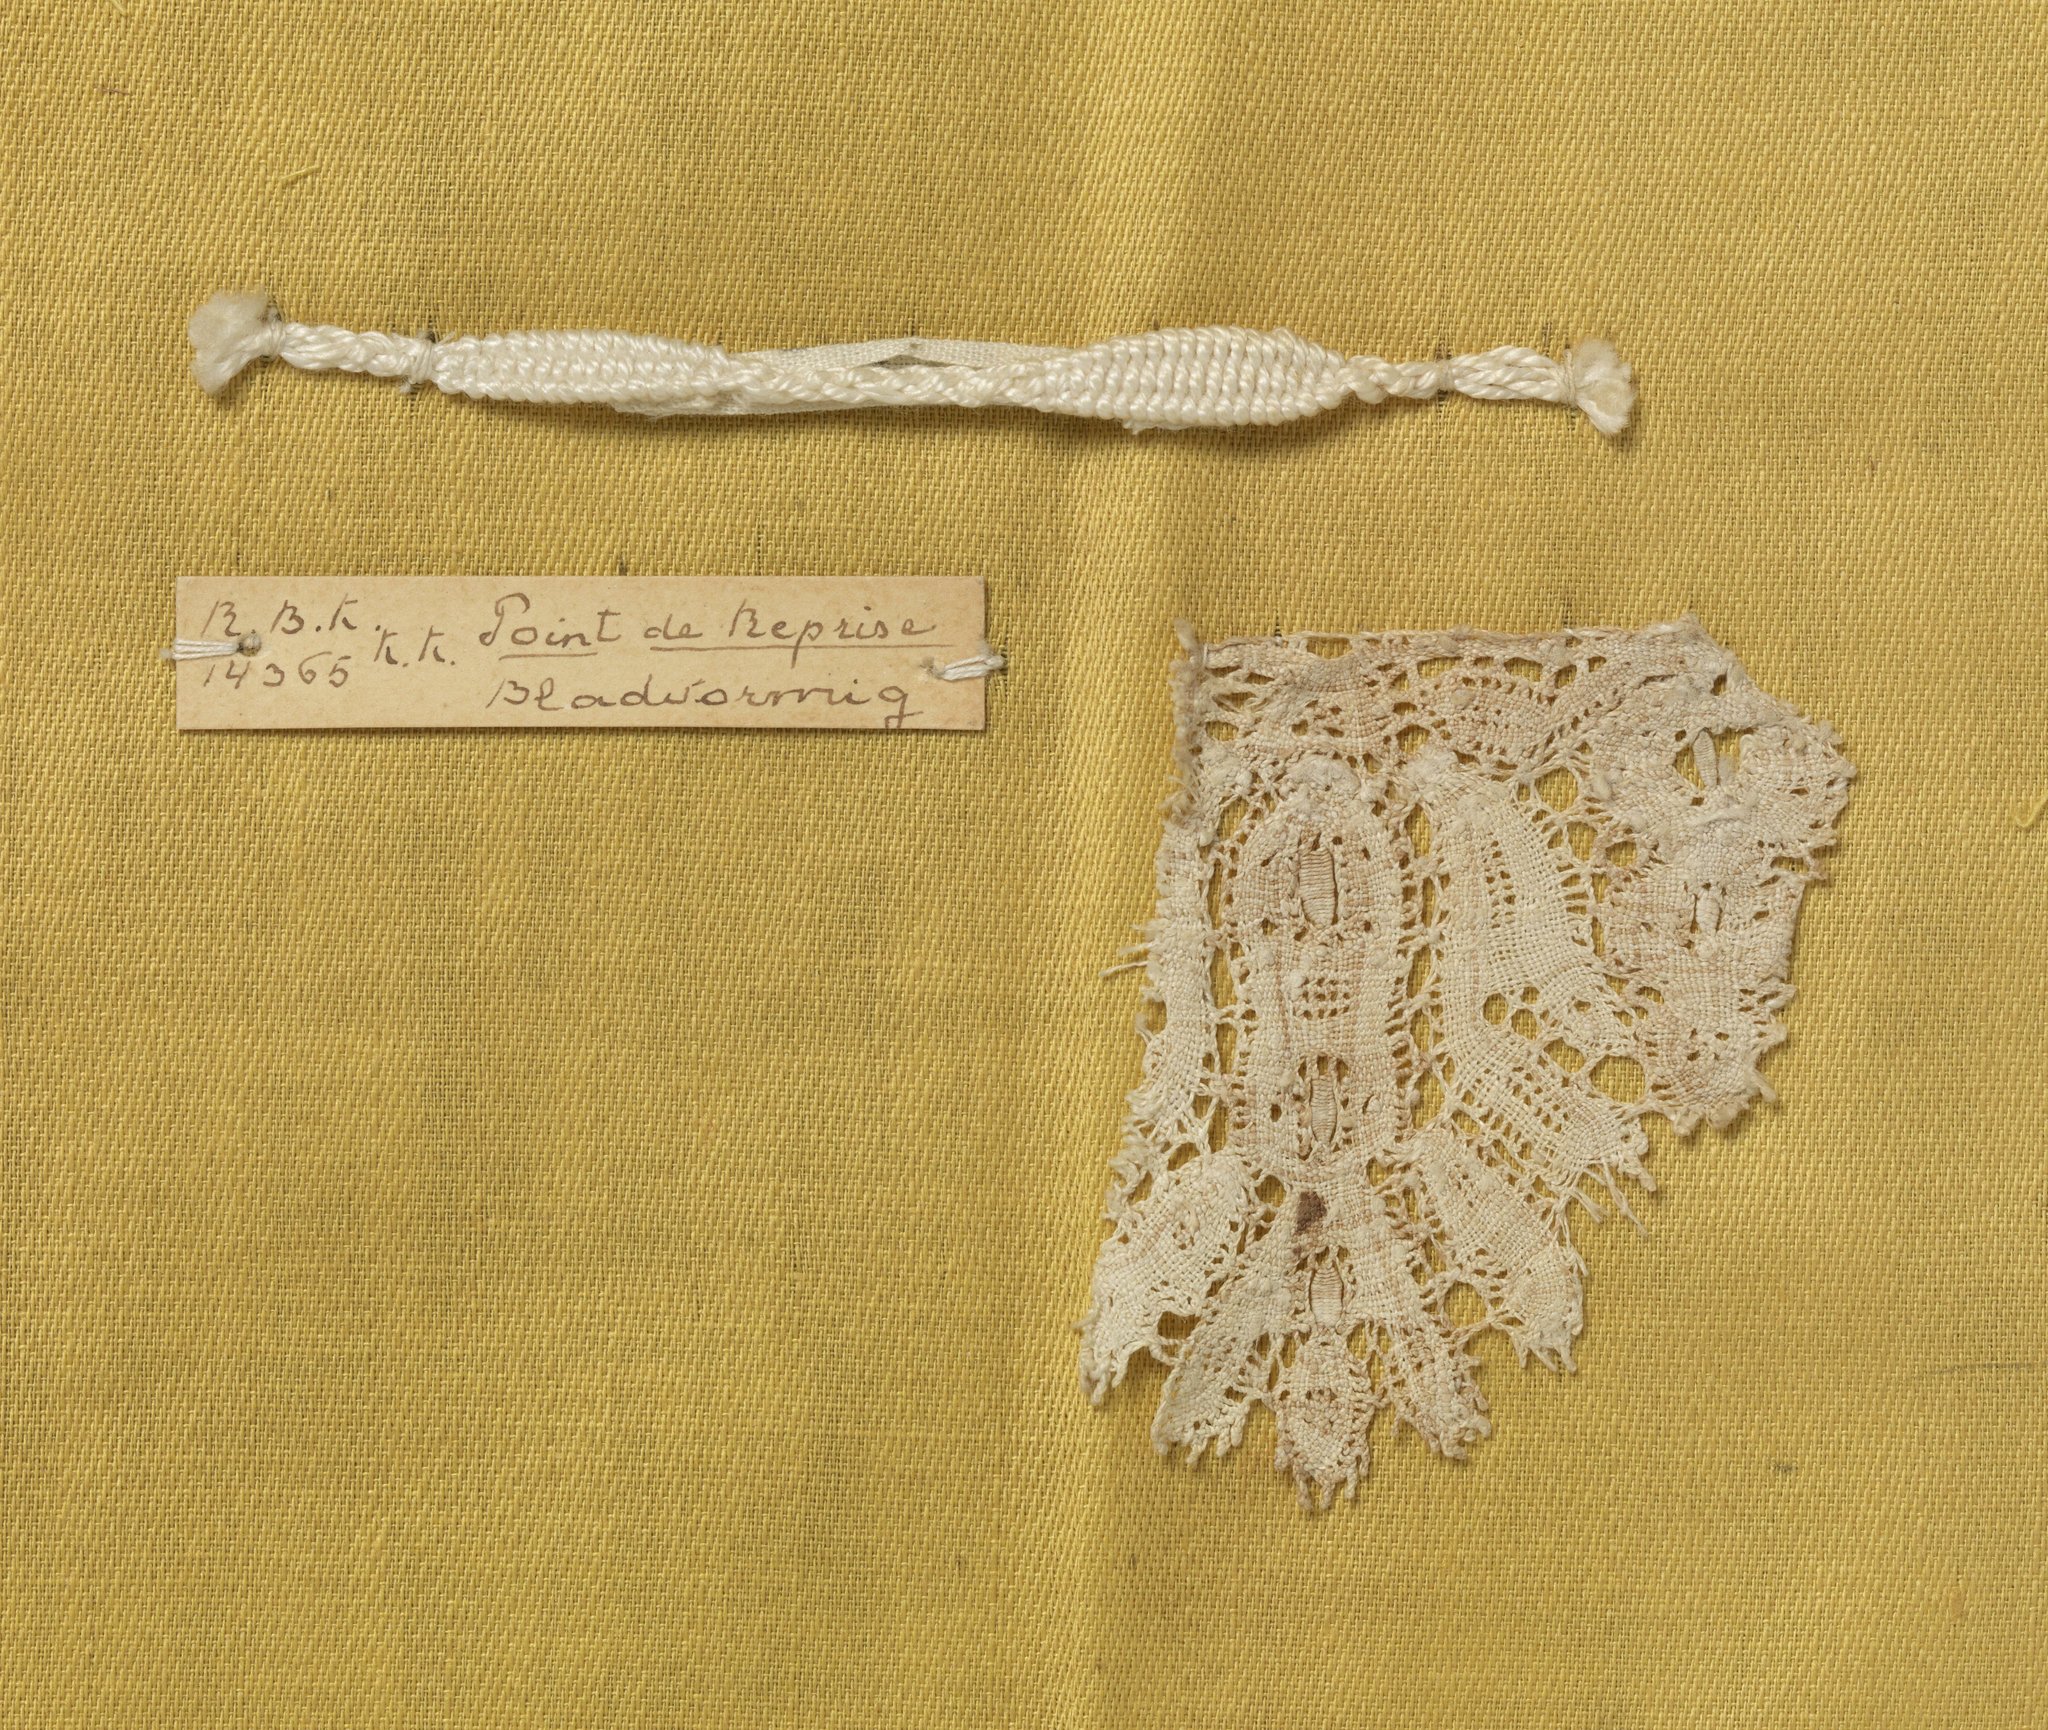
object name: sample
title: Staal kloskant met grove draad als voorbeeld van bladvormige vormslag met daarbij een fragment kant waarin deze techniek is toegepast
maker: Anonymous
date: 1900-1930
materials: cotton, linen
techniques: lace, tally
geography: western europe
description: Staal naturelkleurige kloskant met grove draad als voorbeeld van bladvormige vormslag met daarbij een fragment oudvlaamse kant waarin deze techniek is toegepast. De datering betreft het staal.